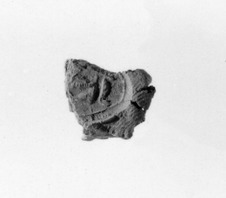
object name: sealing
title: Document Sealing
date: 1390-1352 BCE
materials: mud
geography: egypt